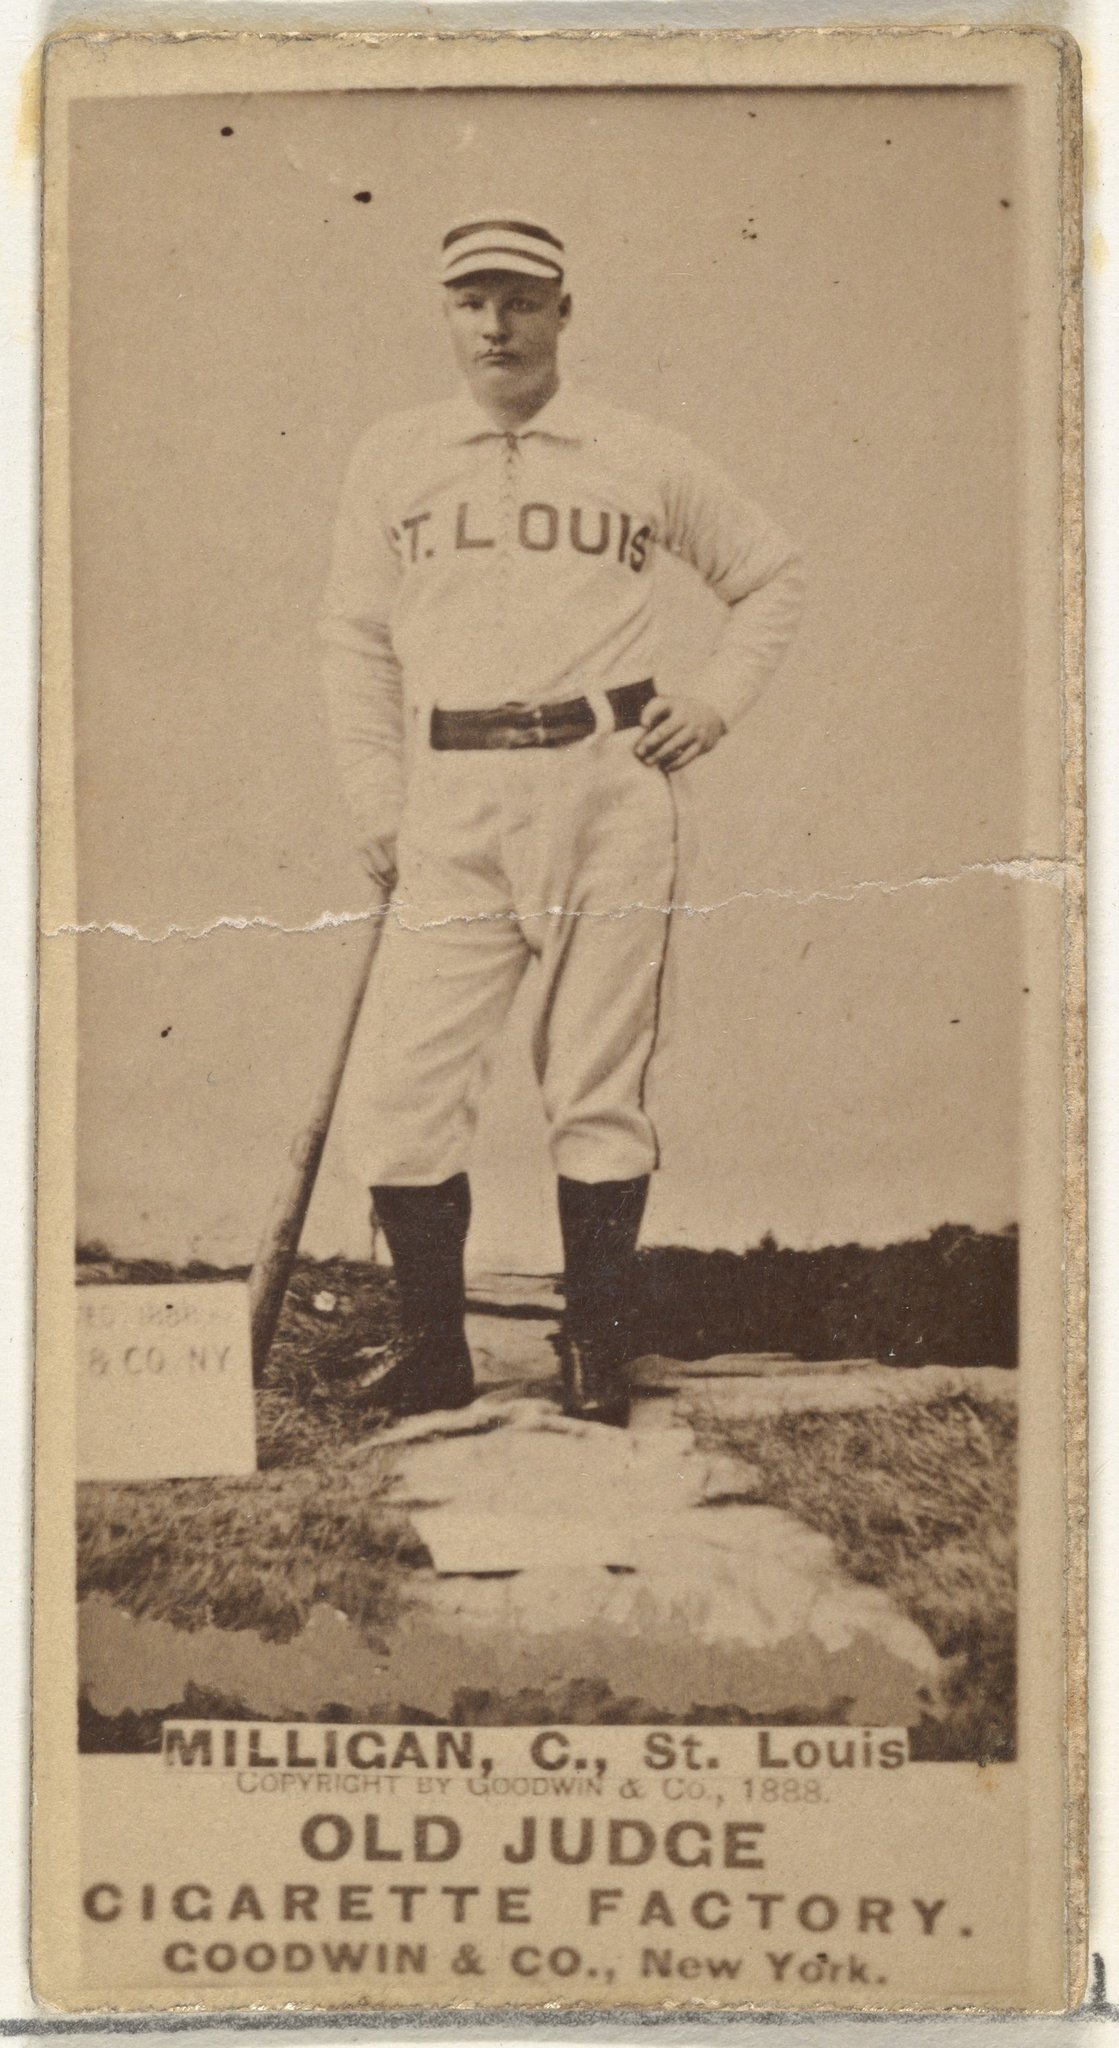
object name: baseball card, photograph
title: Jocko Milligan, Catcher, St. Louis Browns, from the Old Judge series (N172) for Old Judge Cigarettes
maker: goodwin & company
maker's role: publisher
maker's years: 1850-1950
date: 1888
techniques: albumen silver print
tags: men,portraits,baseball,athletes